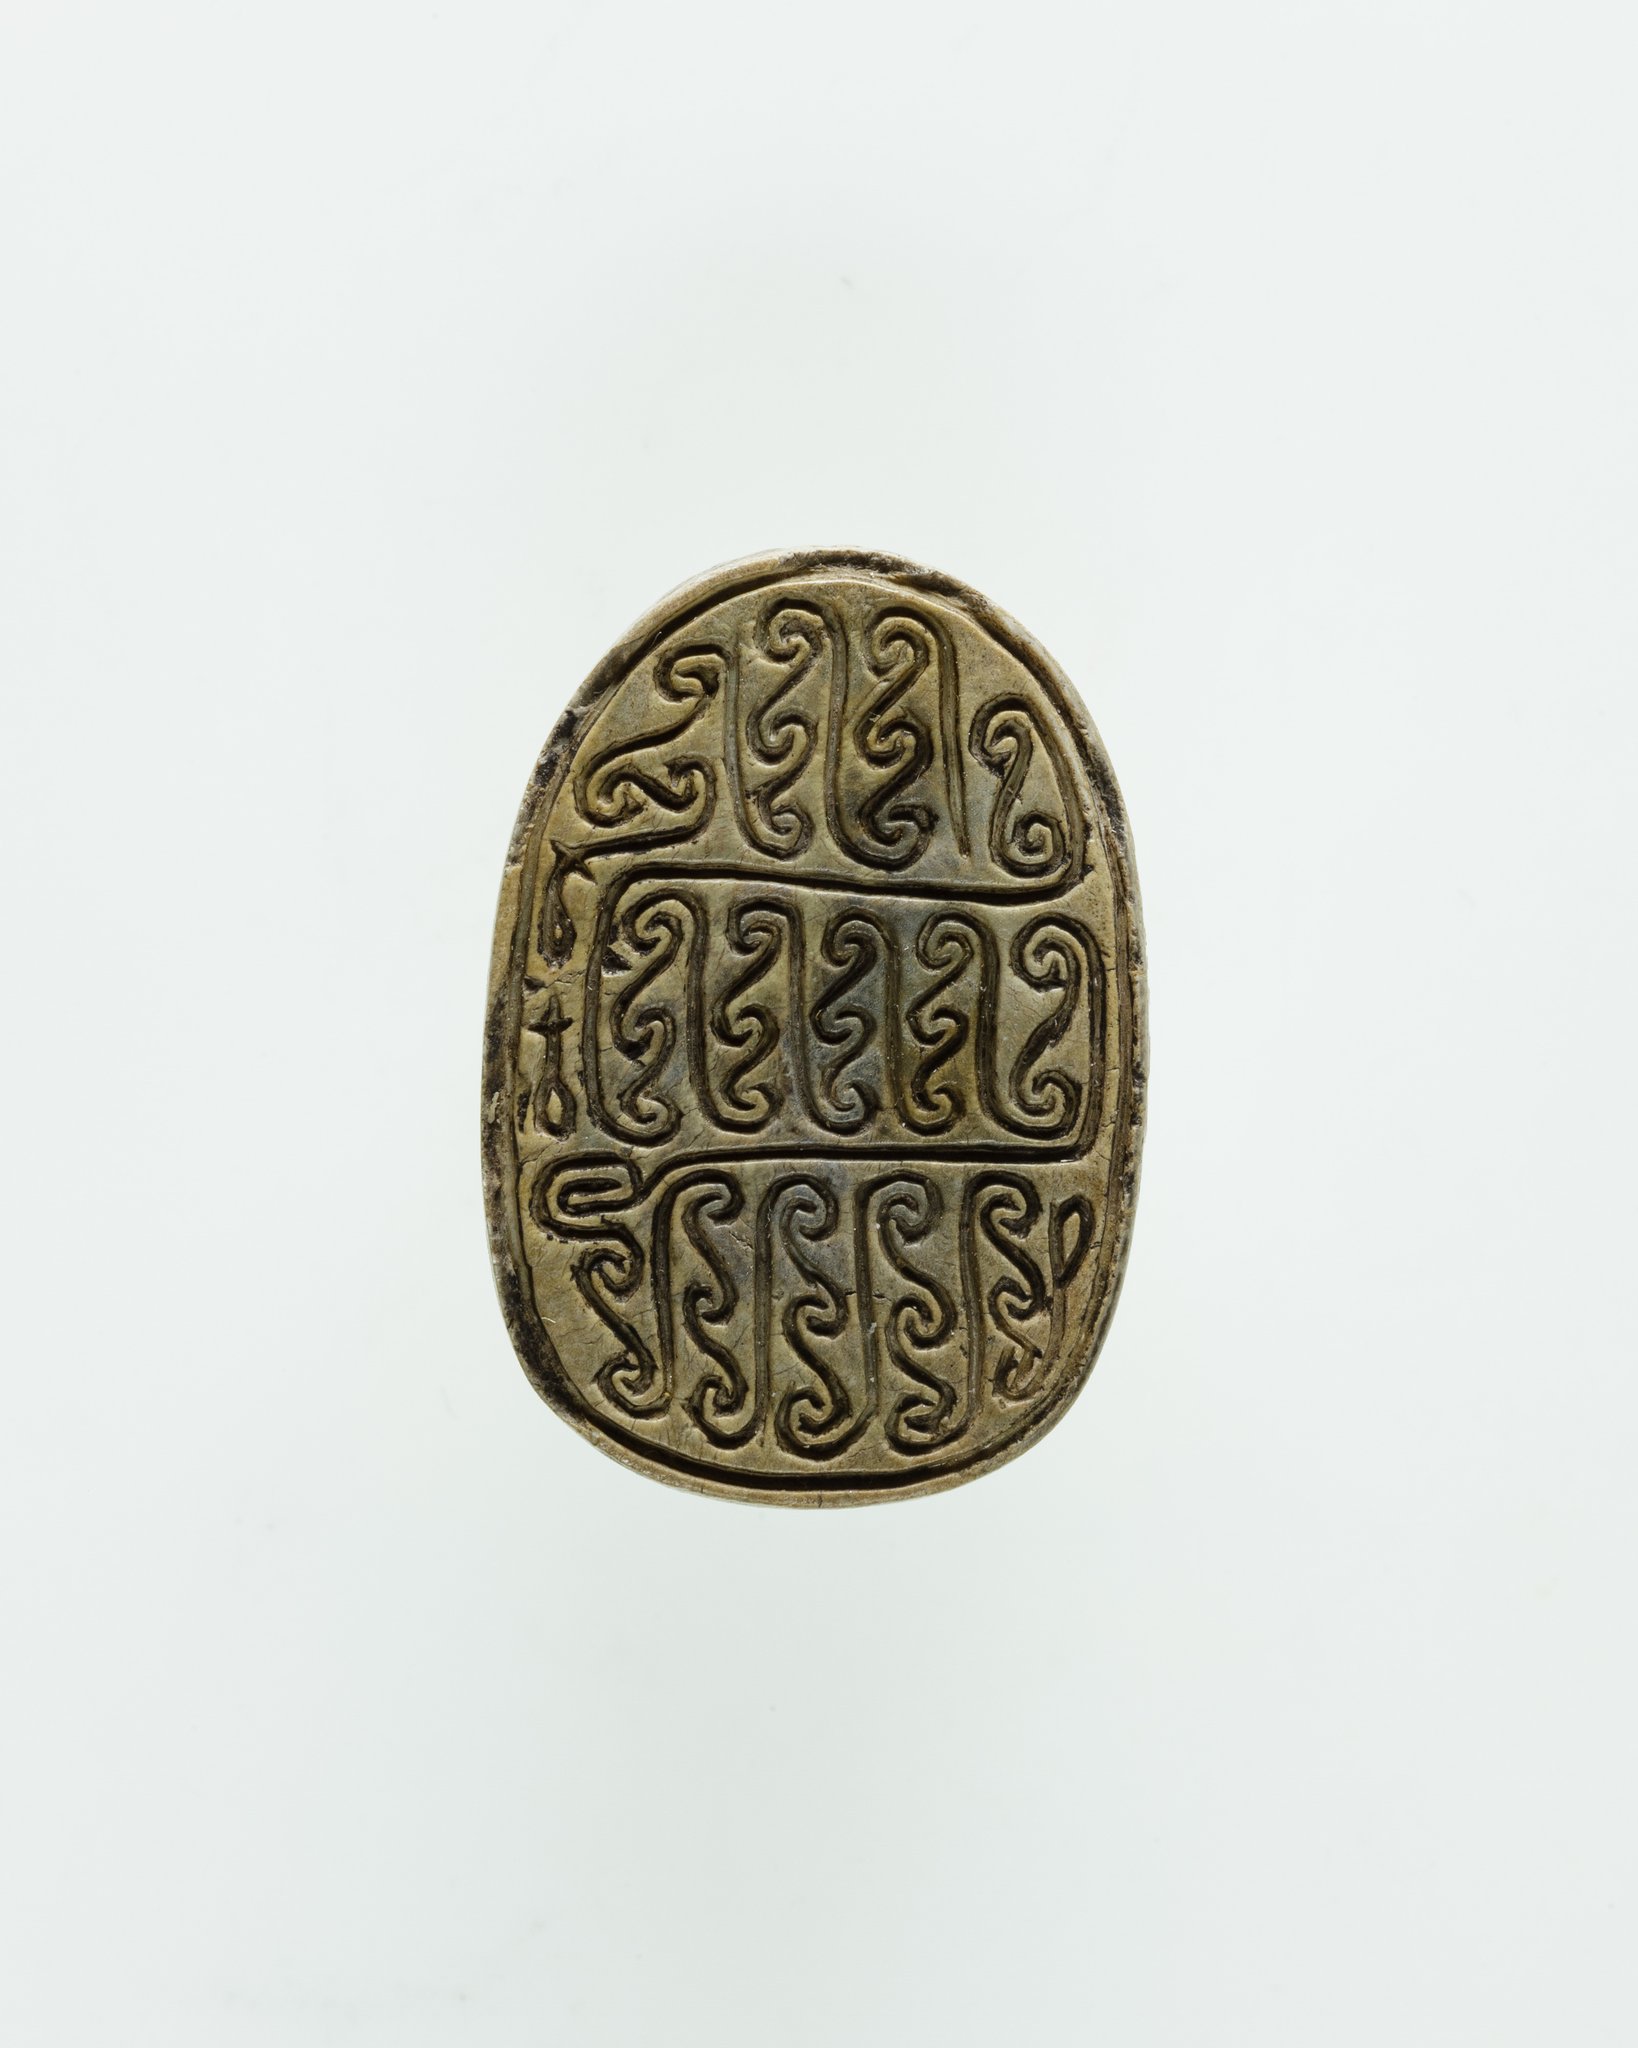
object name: scarab, scroll, hieroglyph, nefer, lotus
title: Scarab Decorated with Scrolls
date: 1760-1670 BCE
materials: stone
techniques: glazing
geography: egypt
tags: scarabs